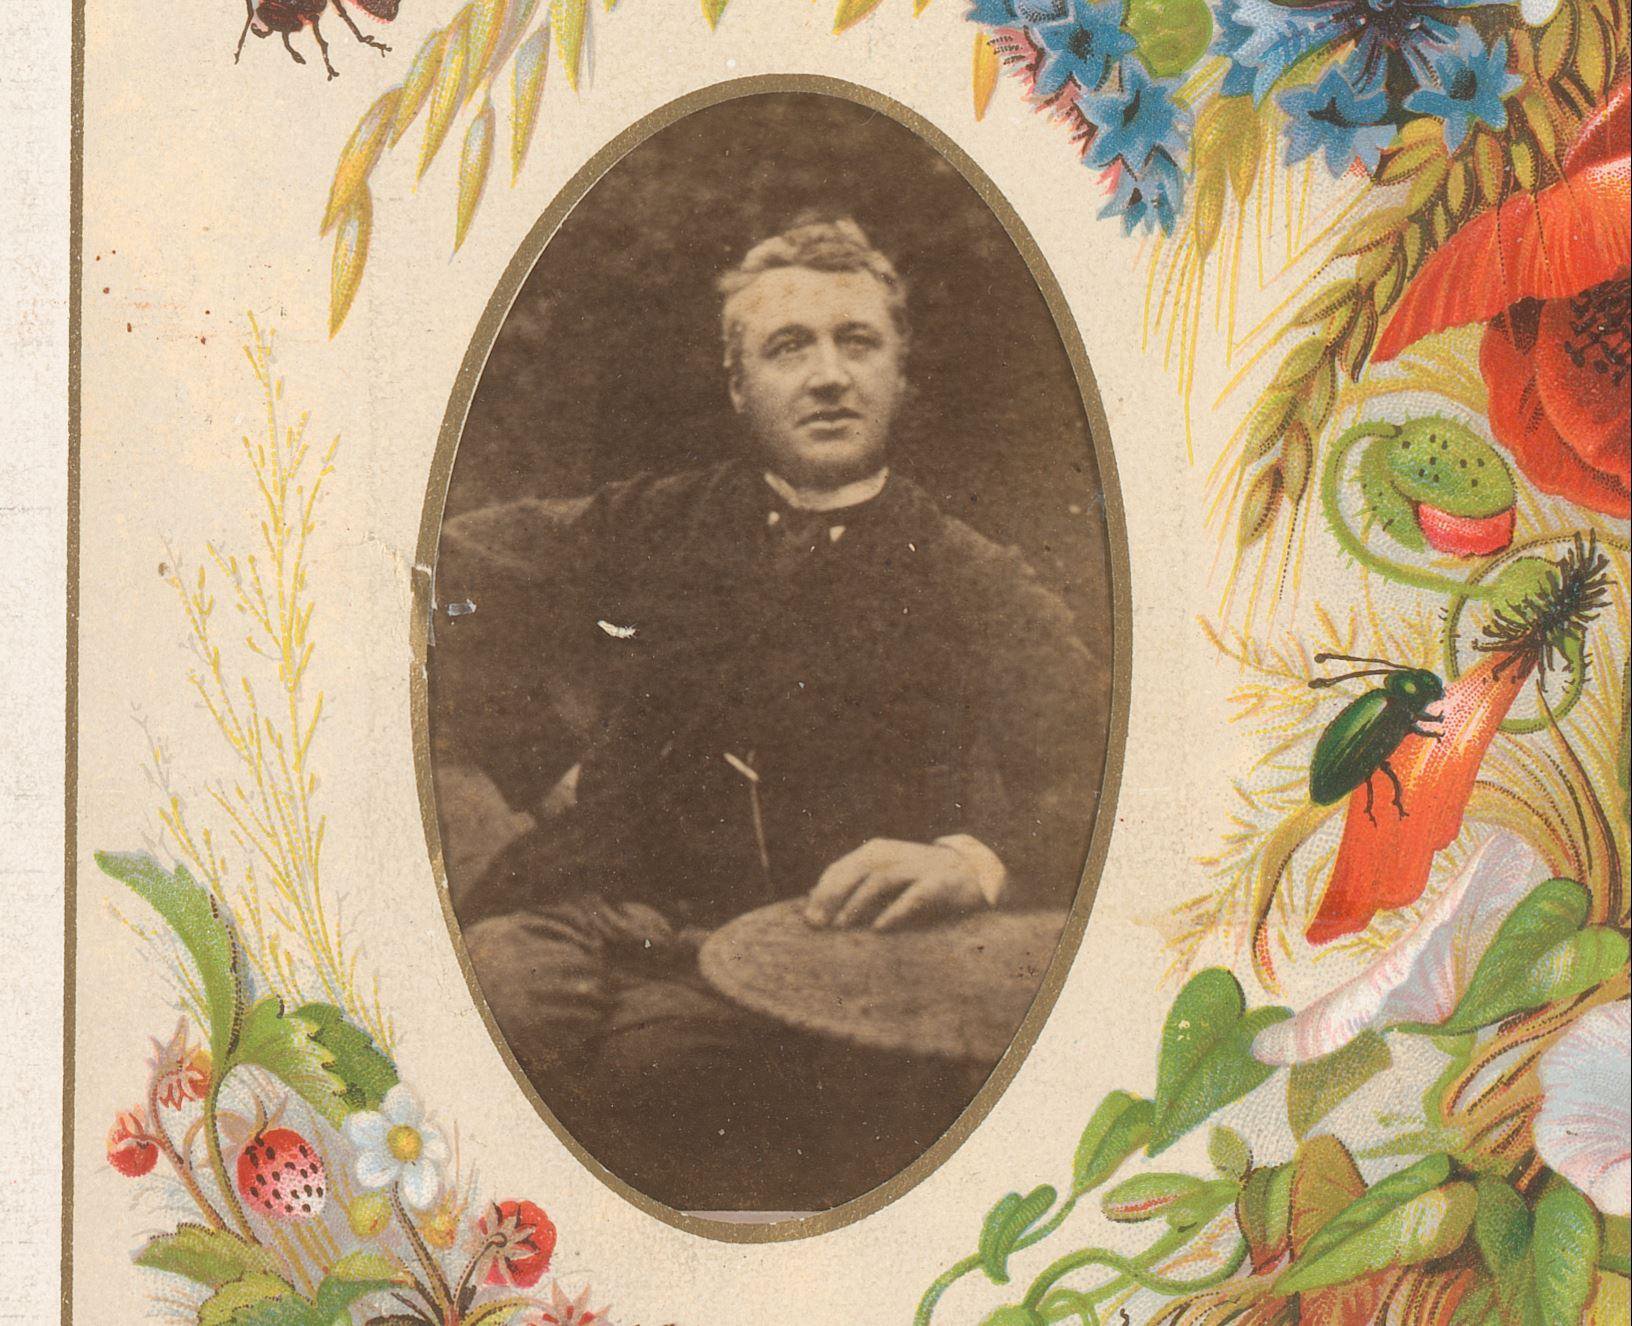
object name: carte de visite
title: Portret van een zittende man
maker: Anonymous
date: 1860-1875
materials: cardboard, paper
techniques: albumen print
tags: sitting figure, adult man, historical persons